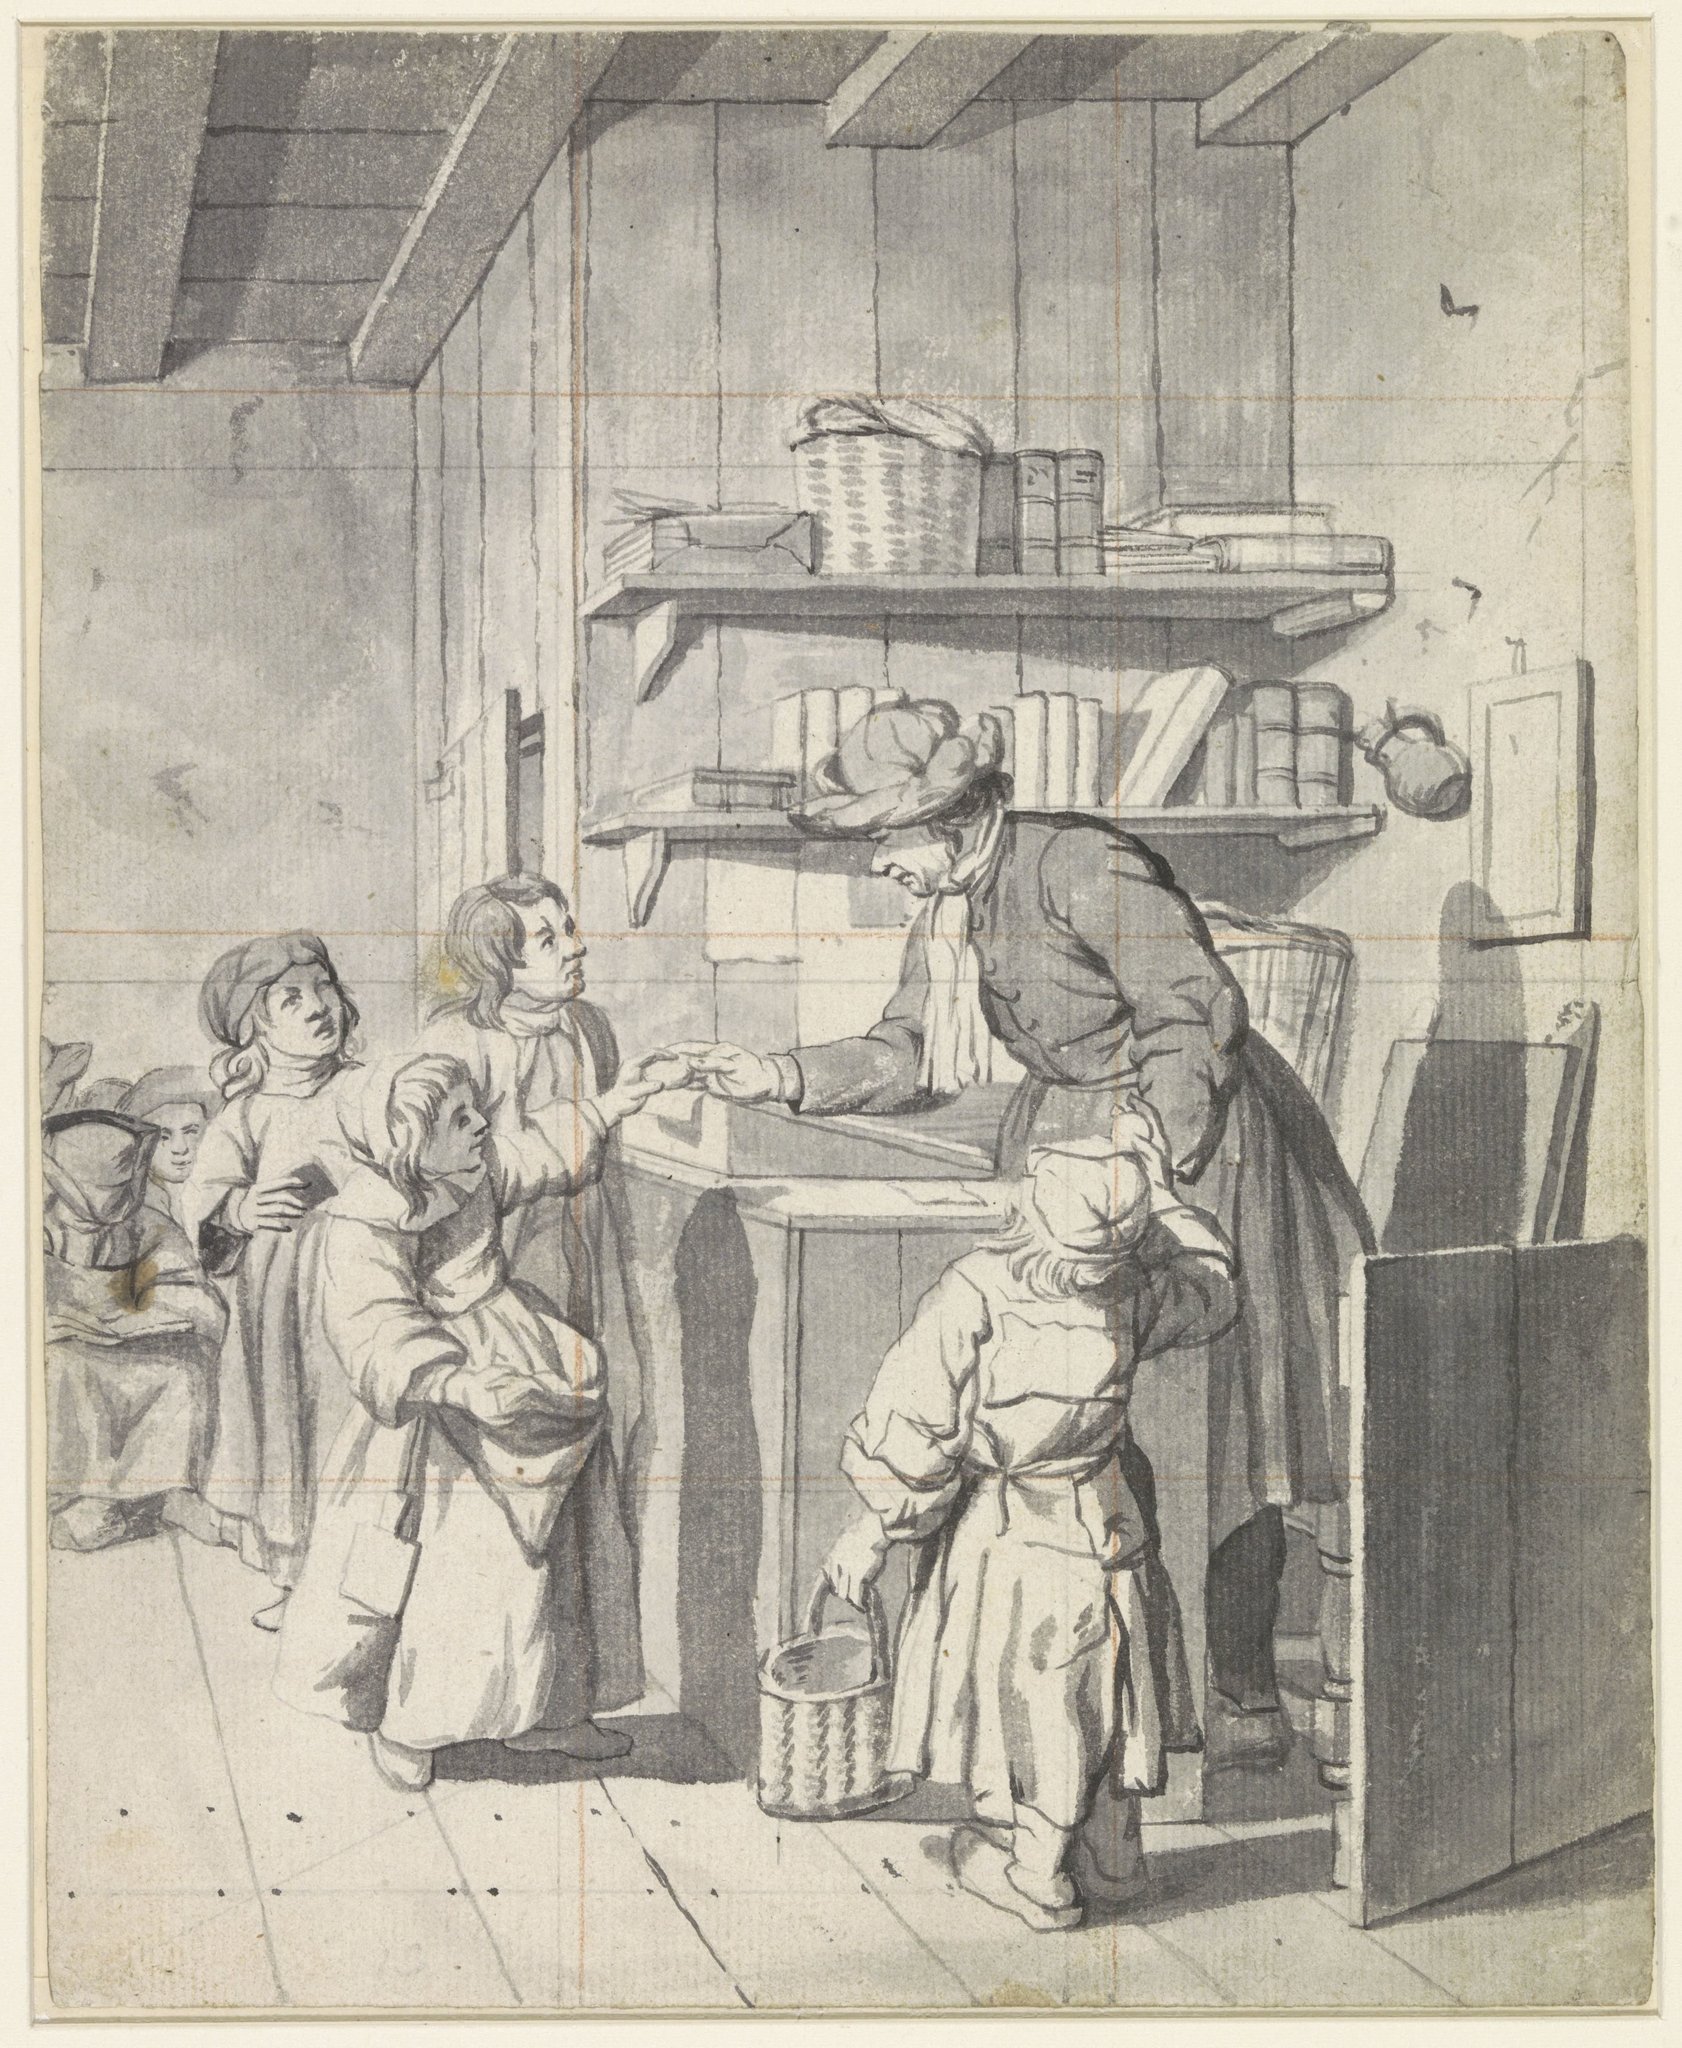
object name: design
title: Schooltje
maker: jan josef horemans (i)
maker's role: draughtsman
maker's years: 1682-1759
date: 1692-1759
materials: chalk, paper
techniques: brush, drawing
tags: elementary school; class, form